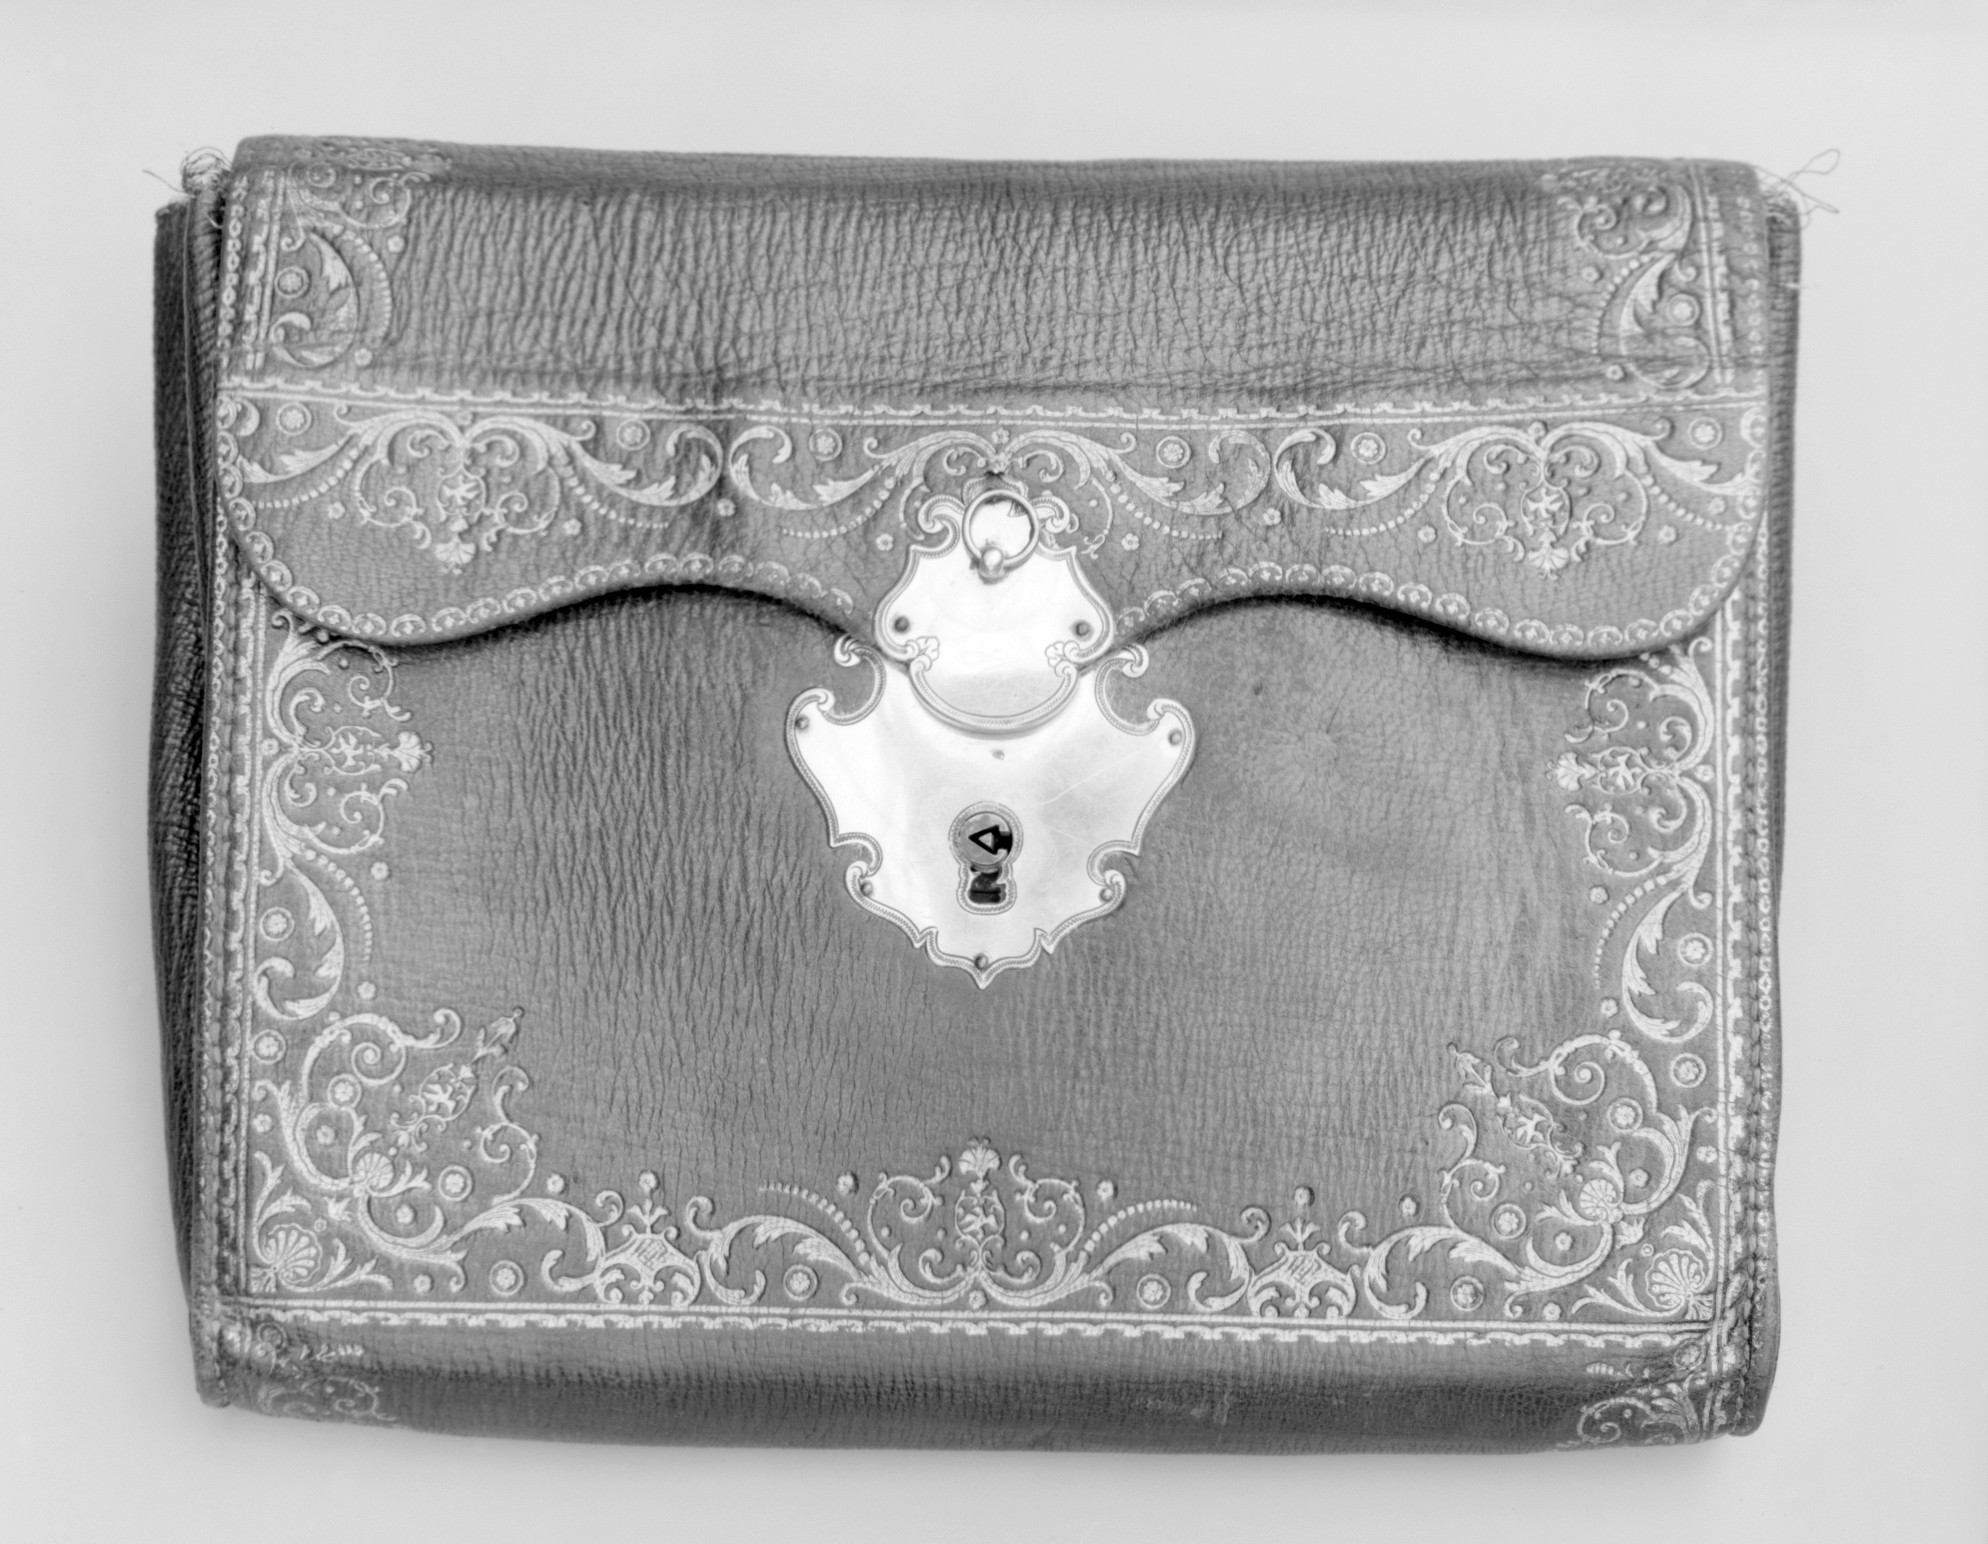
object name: briefcase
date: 1770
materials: gilt, leather, silk, silver